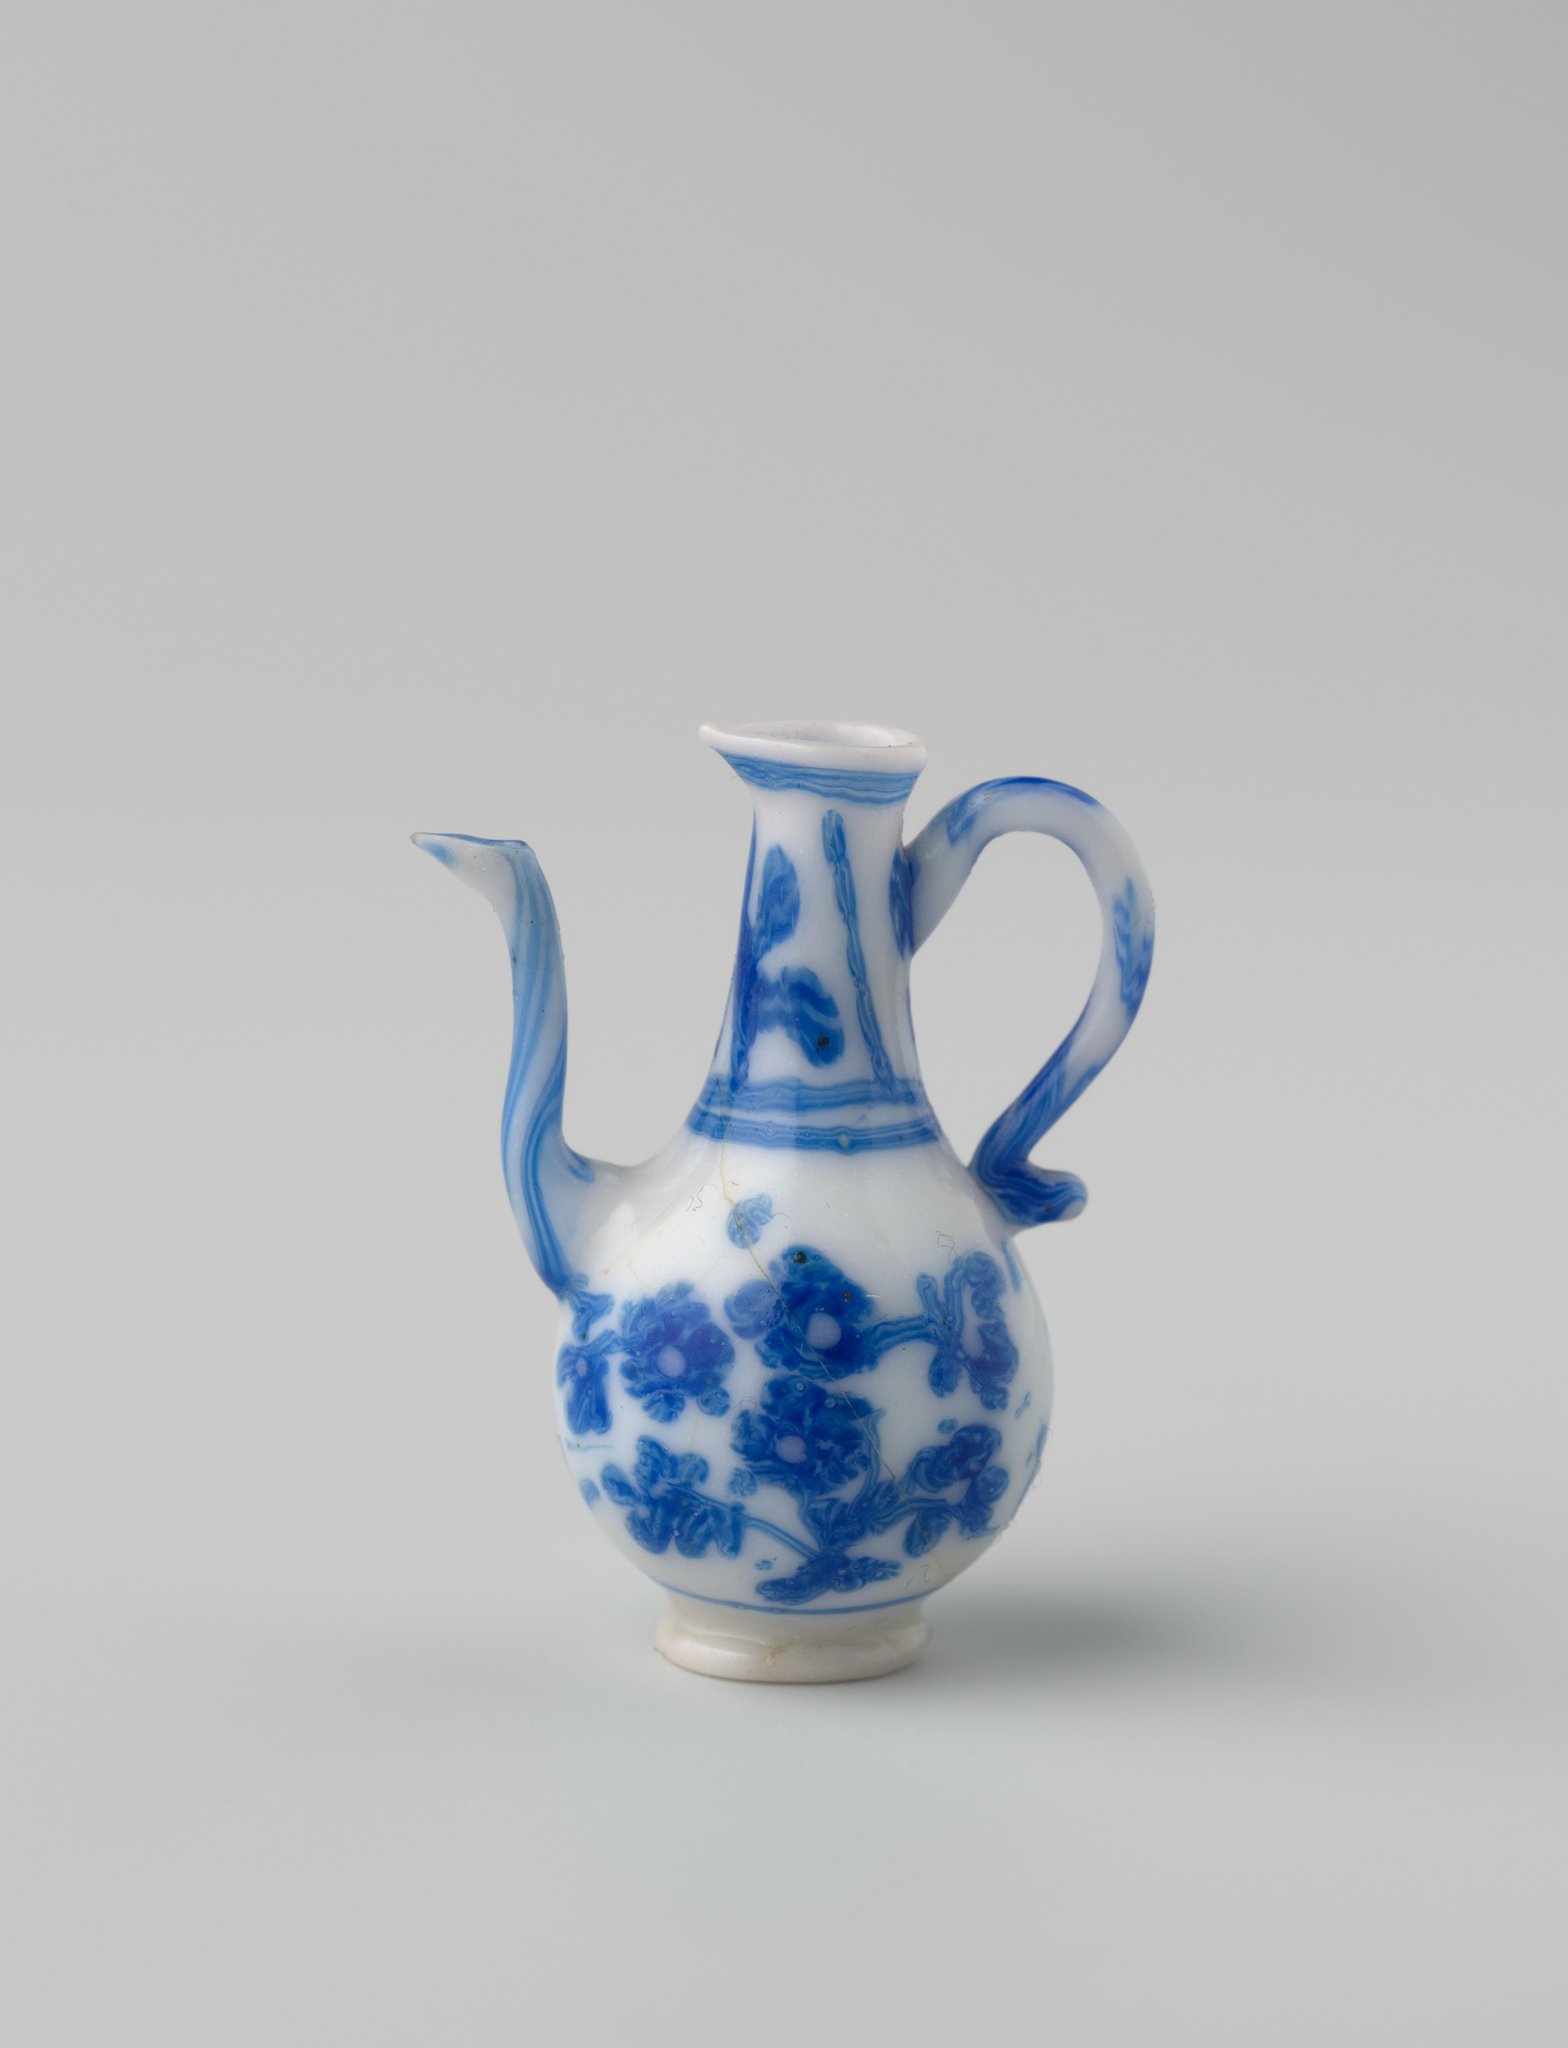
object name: ewer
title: Kan van melkglas met blauwe emailverf beschildering, imitatie Chinees porselein; decoratie van twee bloemtakken op de buik en bloemen in twee vakken op de hals. Peervormig.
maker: Anonymous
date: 1675-1710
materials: glass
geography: amsterdam